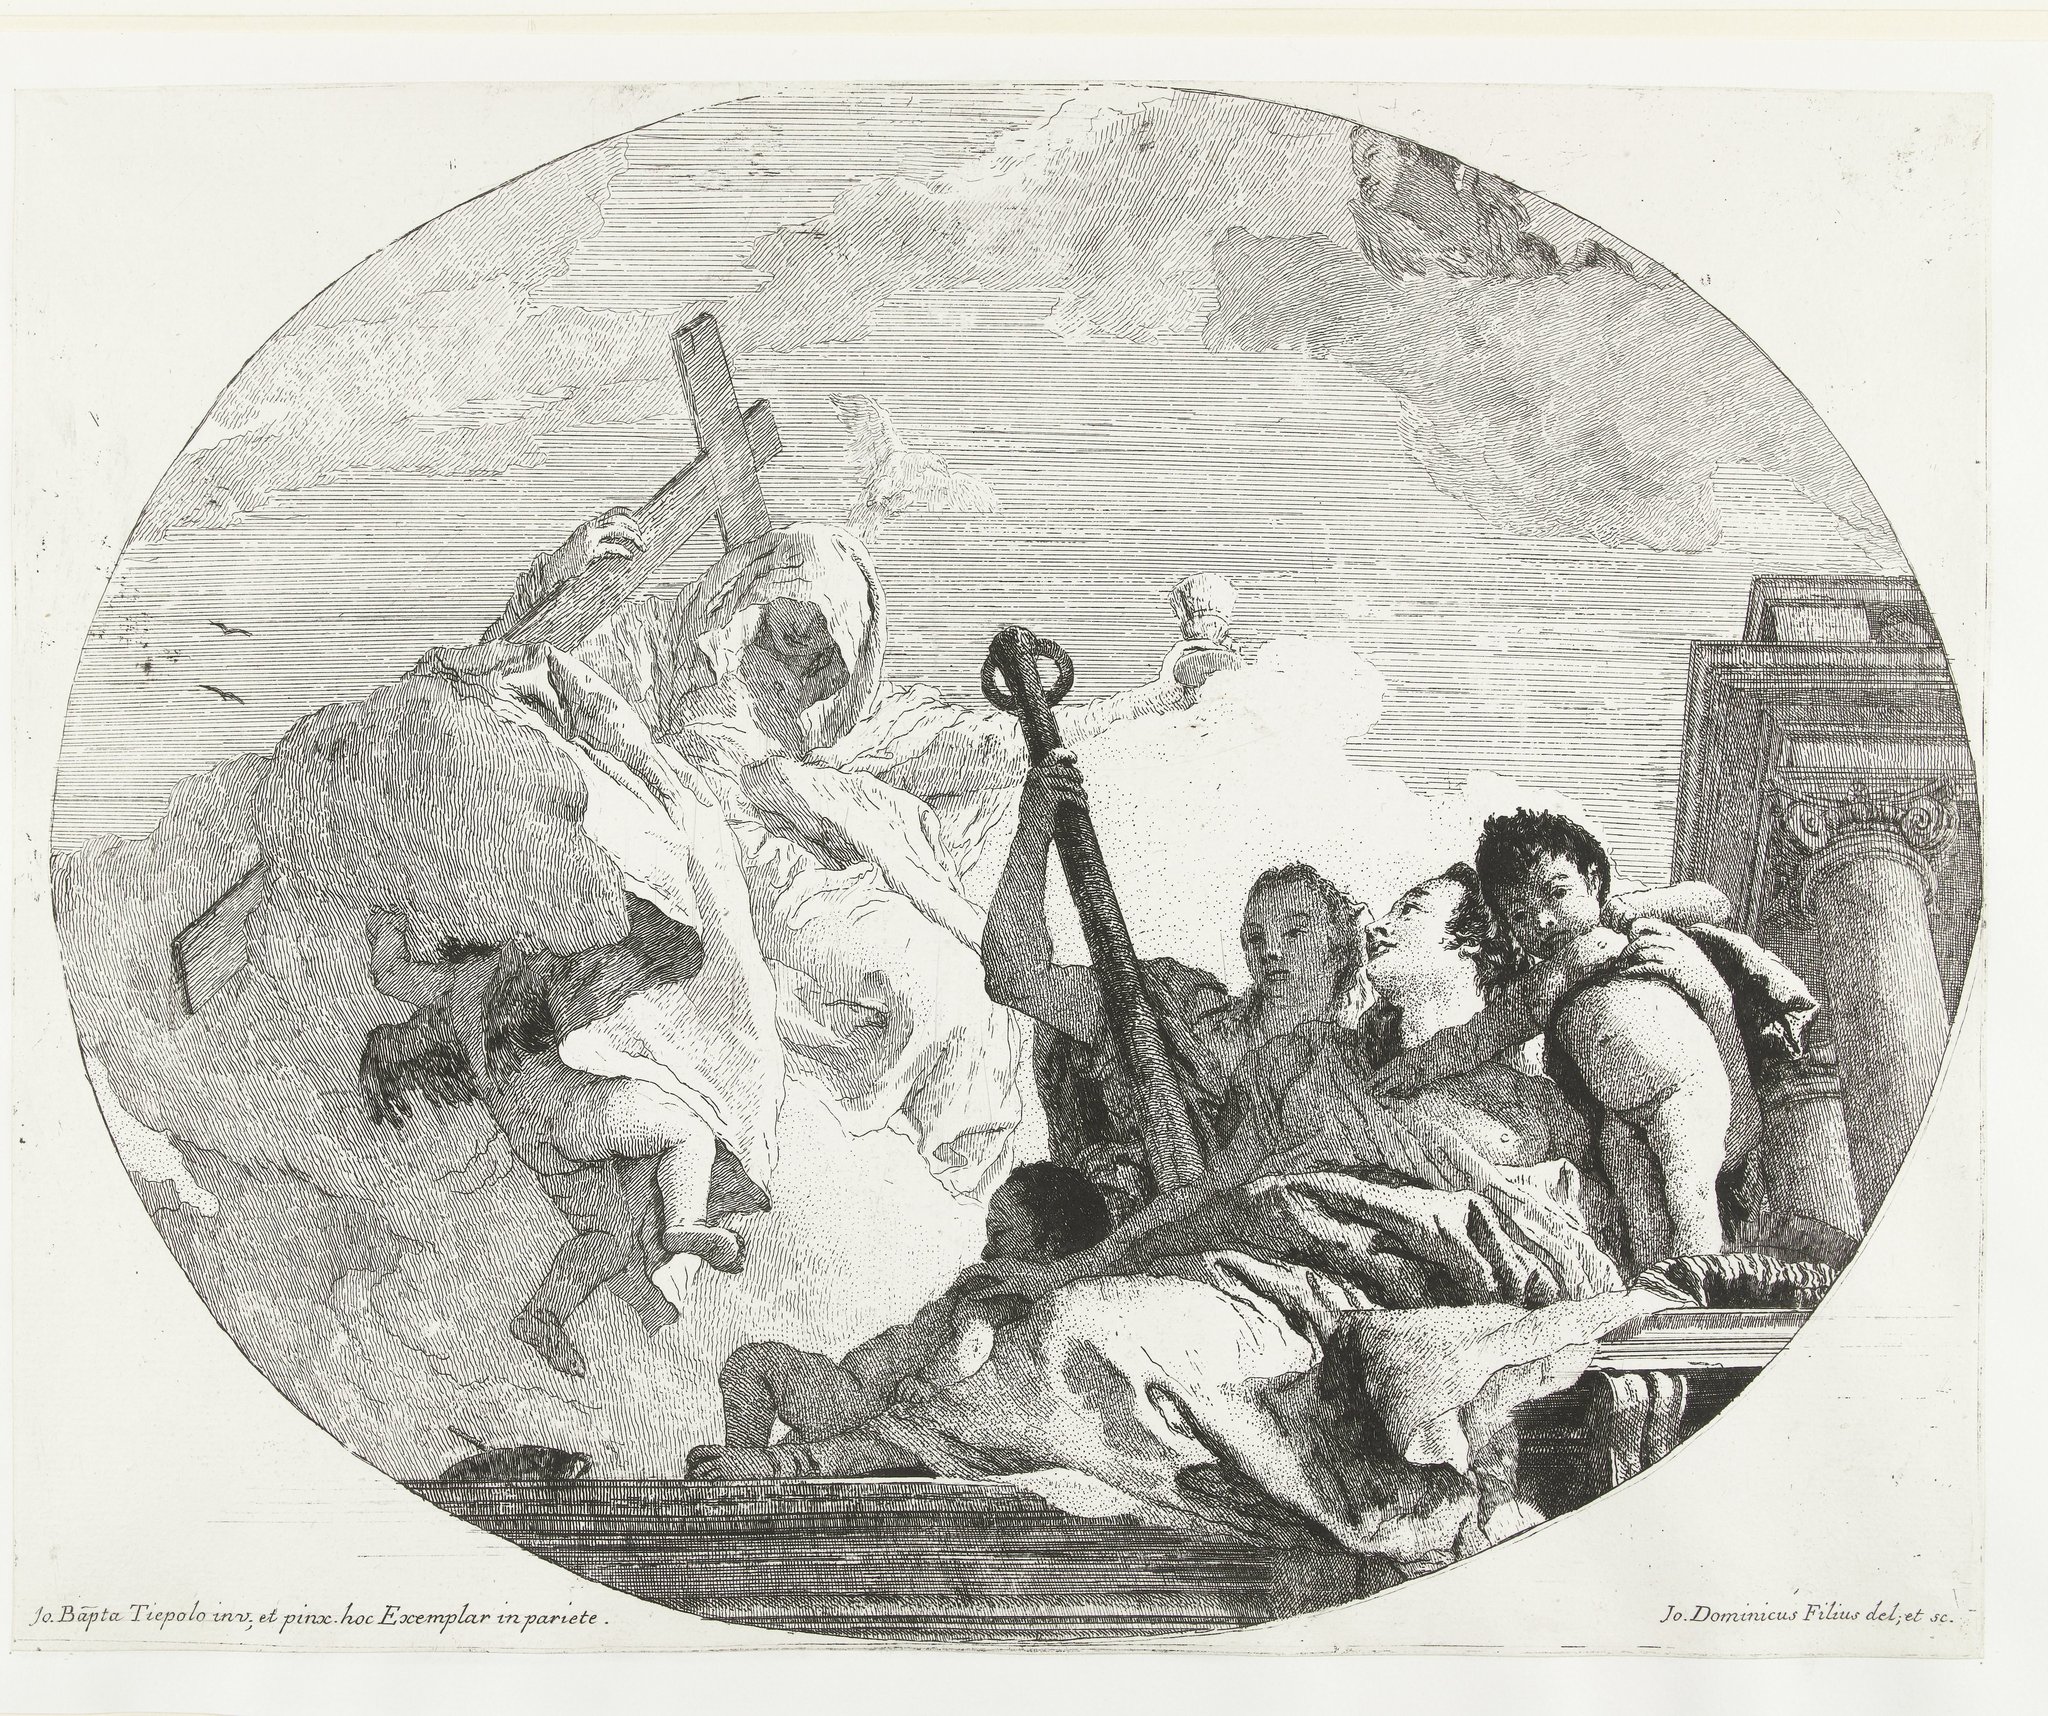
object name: print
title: Drie goddelijke deugden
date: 1753-1757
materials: paper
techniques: etching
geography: venice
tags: charity, 'caritas'; 'carità' (ripa) ~ one of the three theological virtues, faith, 'fides'; 'fede', 'fede catholica', 'fede christiana', 'fede christiana catholica' (ripa) ~ one of the three theological virtues, hope, 'spes'; 'speranza divina e certa' (ripa) ~ one of the three theological virtues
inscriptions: collector's mark: Lugt 2228, collector's mark: Lugt 2760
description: De drie goddelijke deugden geloof (fides) met kruis en miskelk, hoop (spes) met anker en liefde (caritas) met twee kinderen.